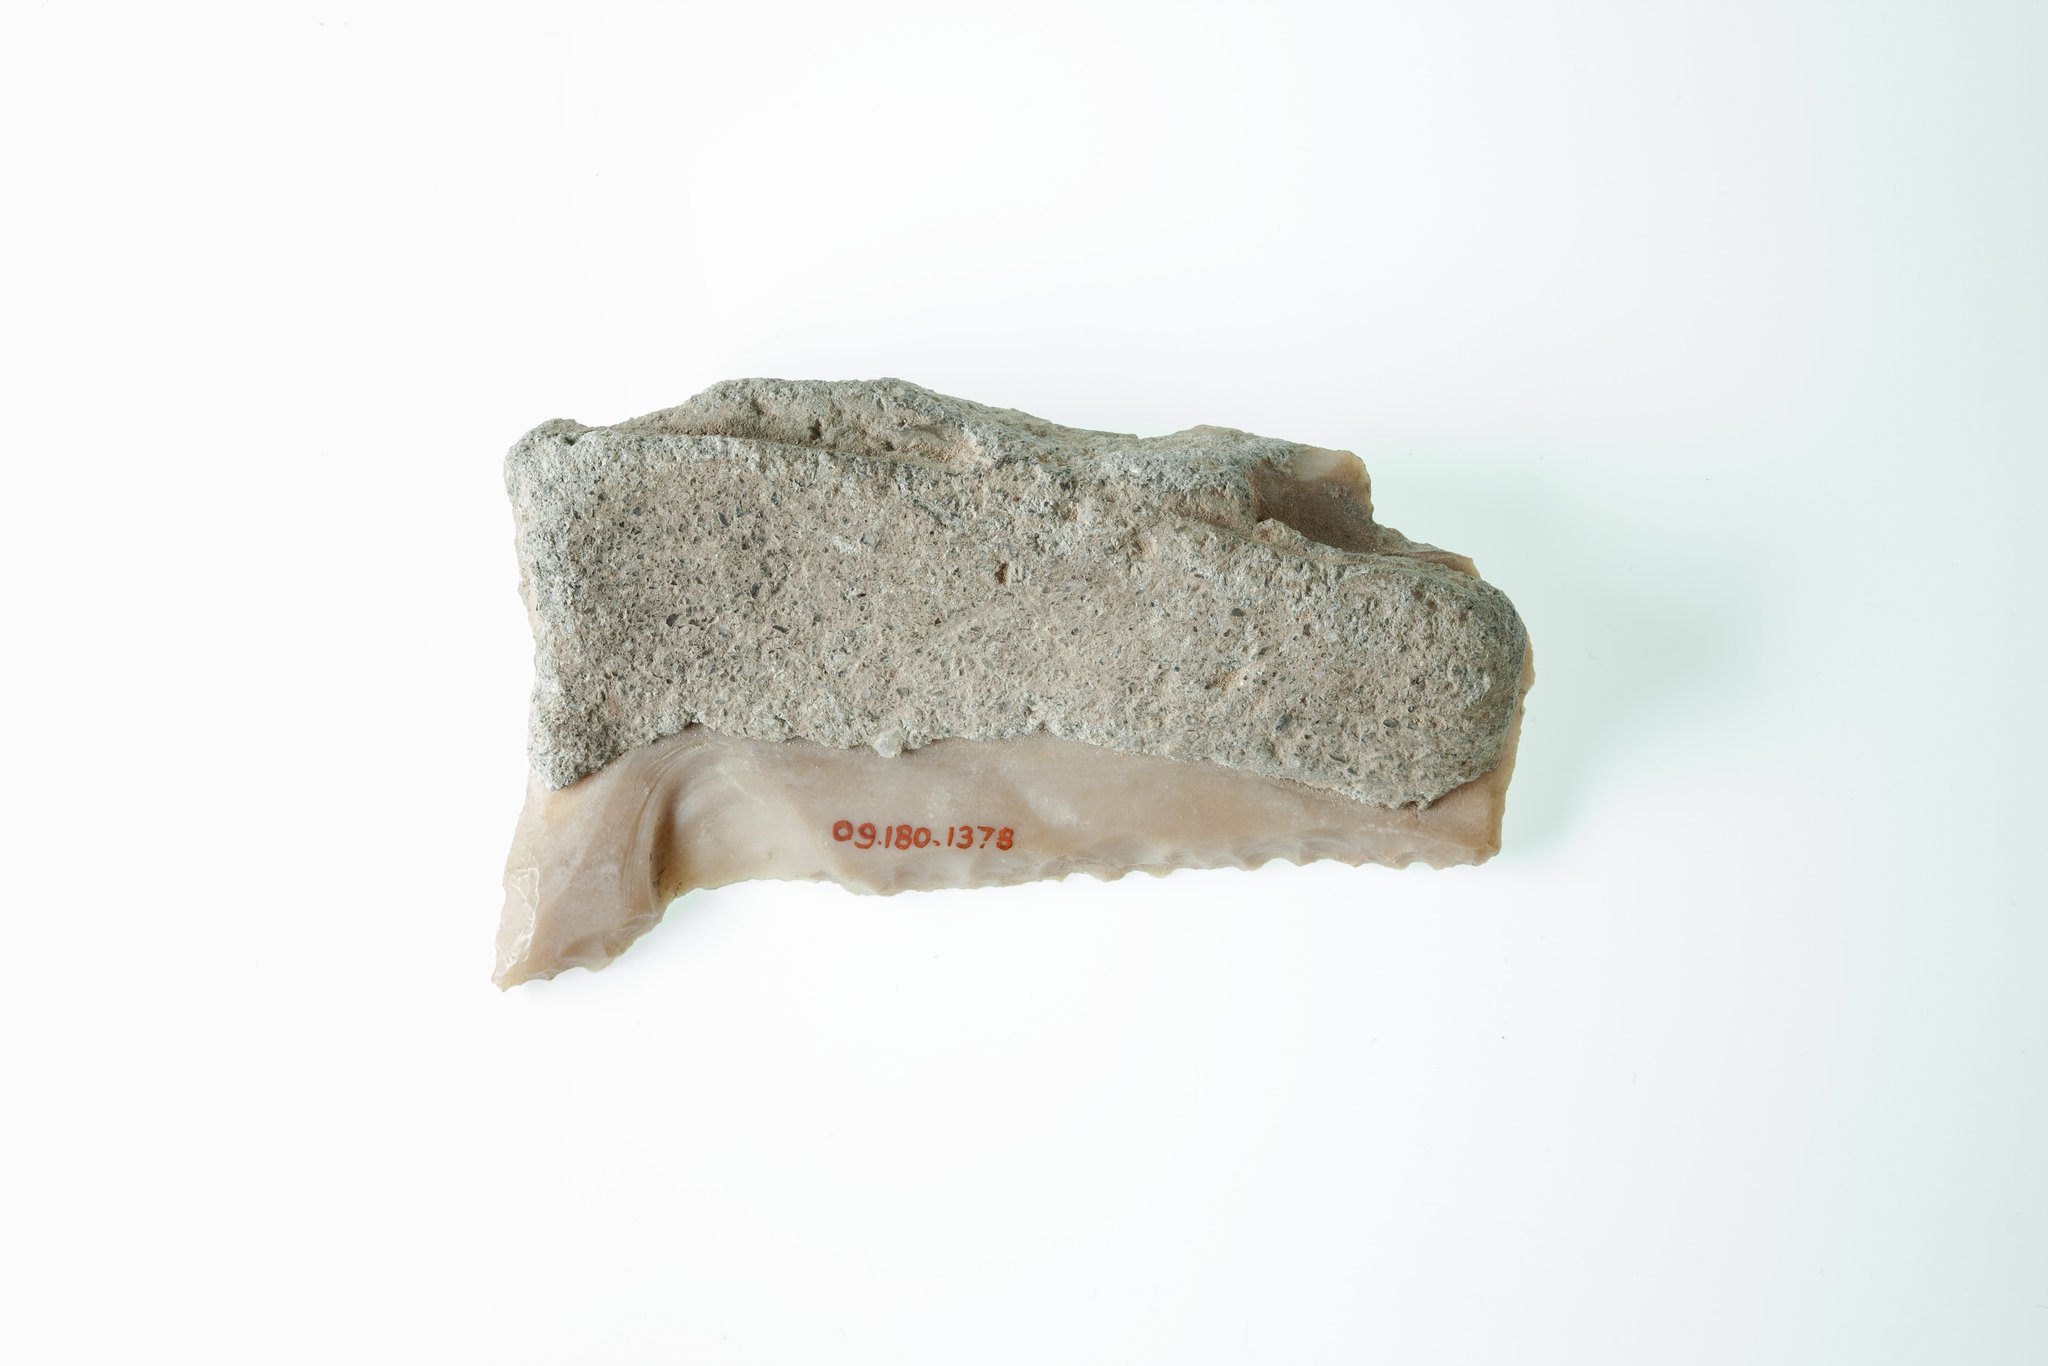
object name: sickle, denticulate, truncated, backed, geometric, tool, element, adhesive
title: Sickle Insert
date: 1186-1070 BCE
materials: stone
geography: egypt